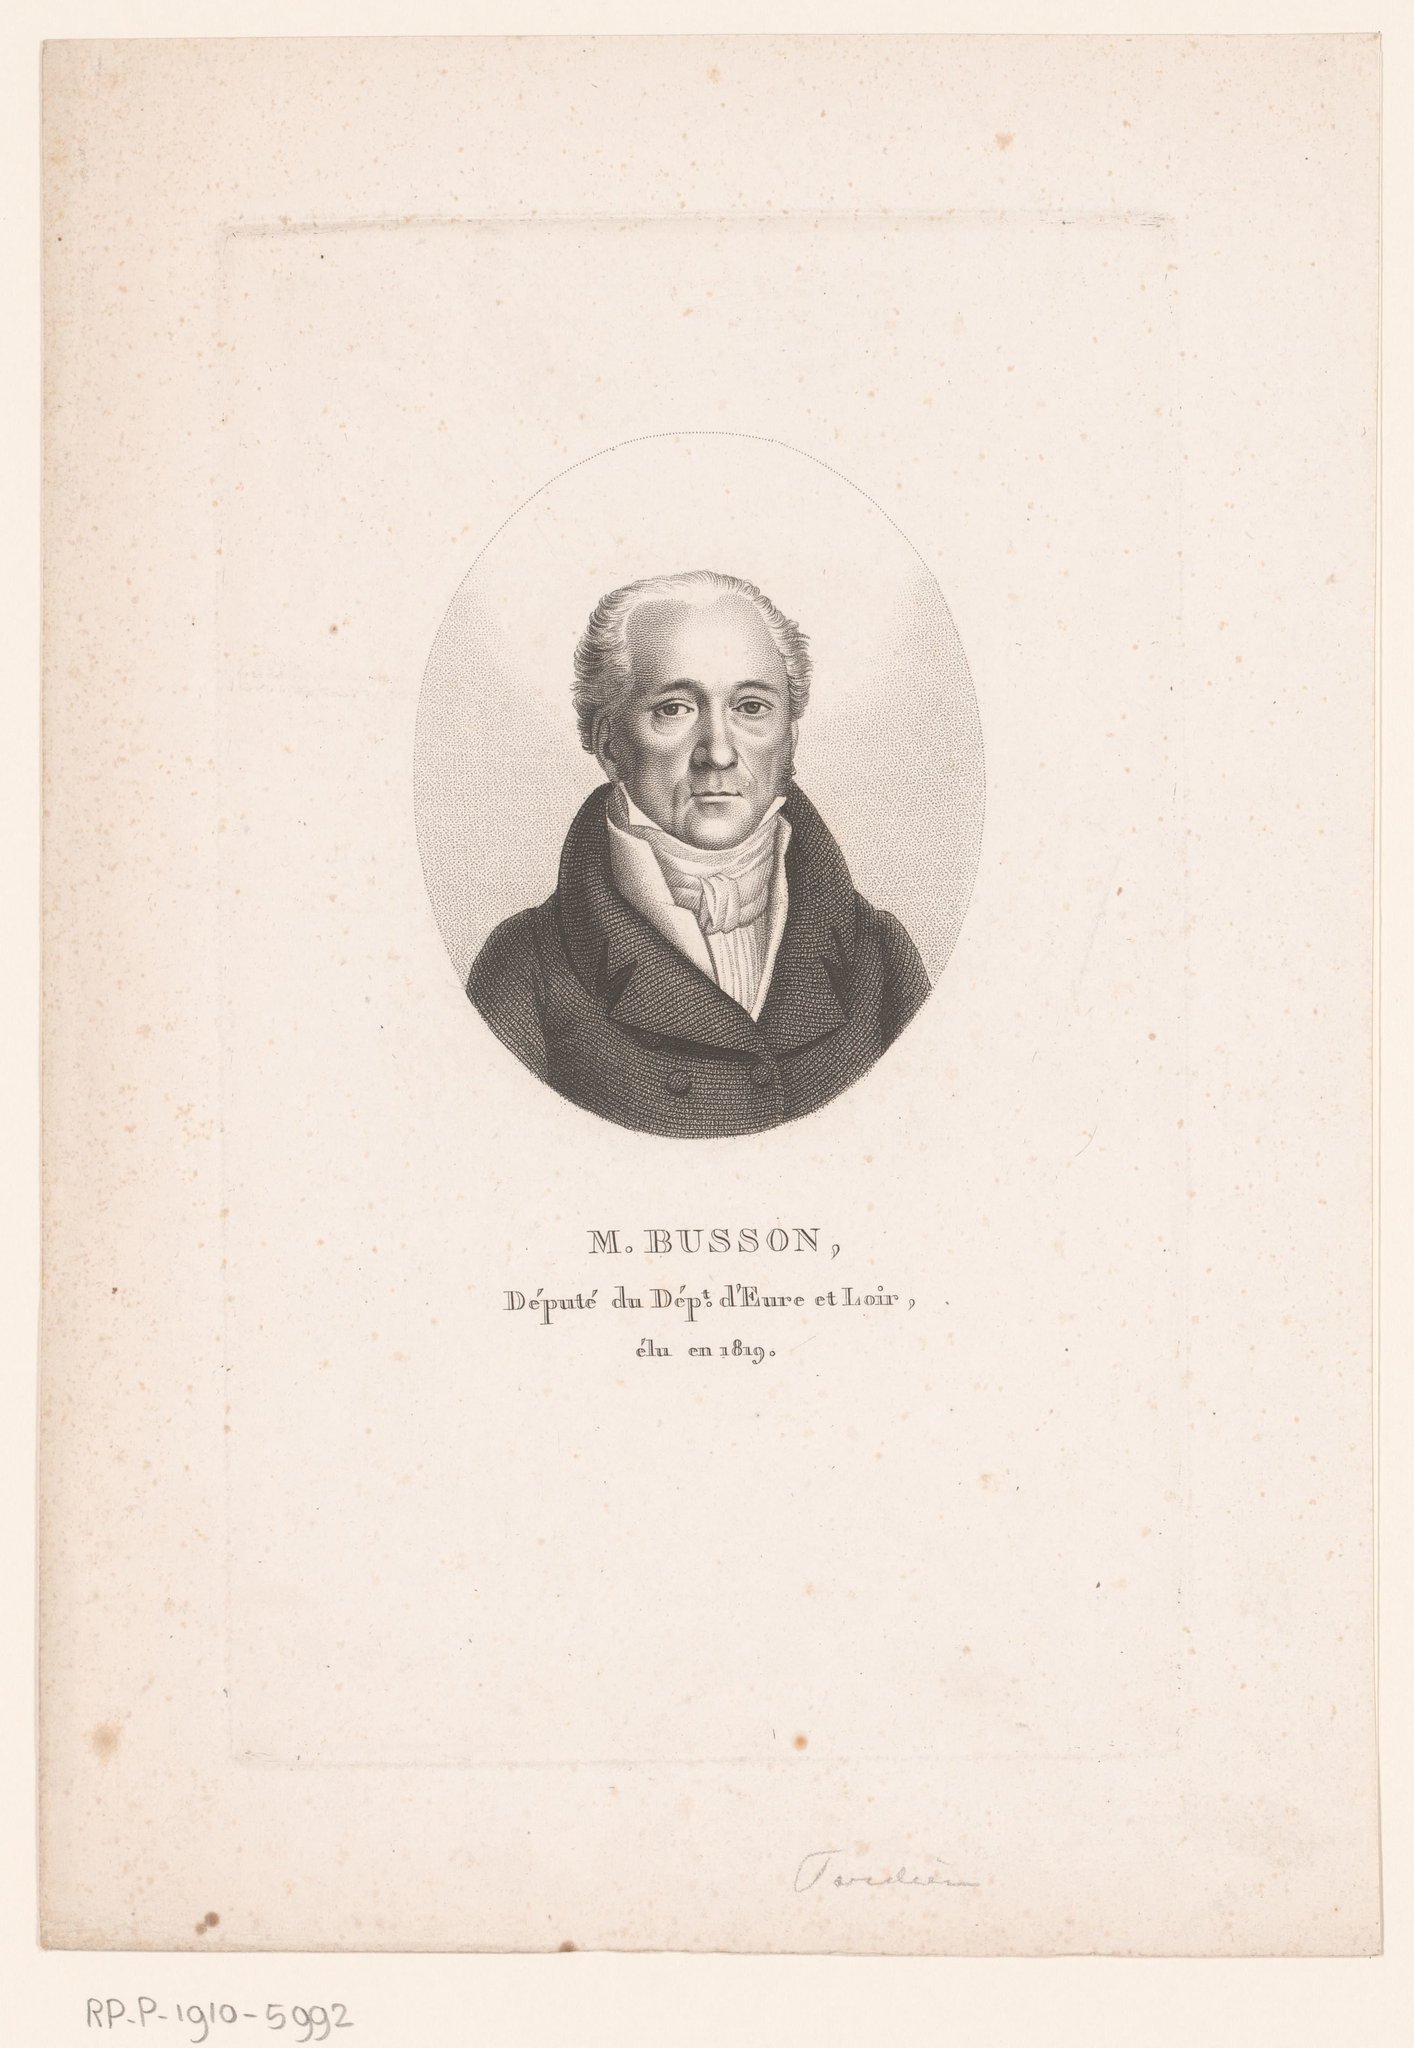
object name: print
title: Portret van Jean-Baptiste Guillaume Busson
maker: ambroise tardieu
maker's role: print maker, printer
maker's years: 1788-1841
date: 1820-1821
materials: paper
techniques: engraving, roulette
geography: paris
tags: politician, historical persons, politician, e.g. party leader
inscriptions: collector's mark: Lugt 2228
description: Prent uit: Tardieu, Ambroise. Portraits des députés, écrivains et pairs constitutionnels, défenseurs invariables de la charte et de la loi des élections du 5 février 1817. Parijs: Tardieu, Ambroise, 1820-1821.